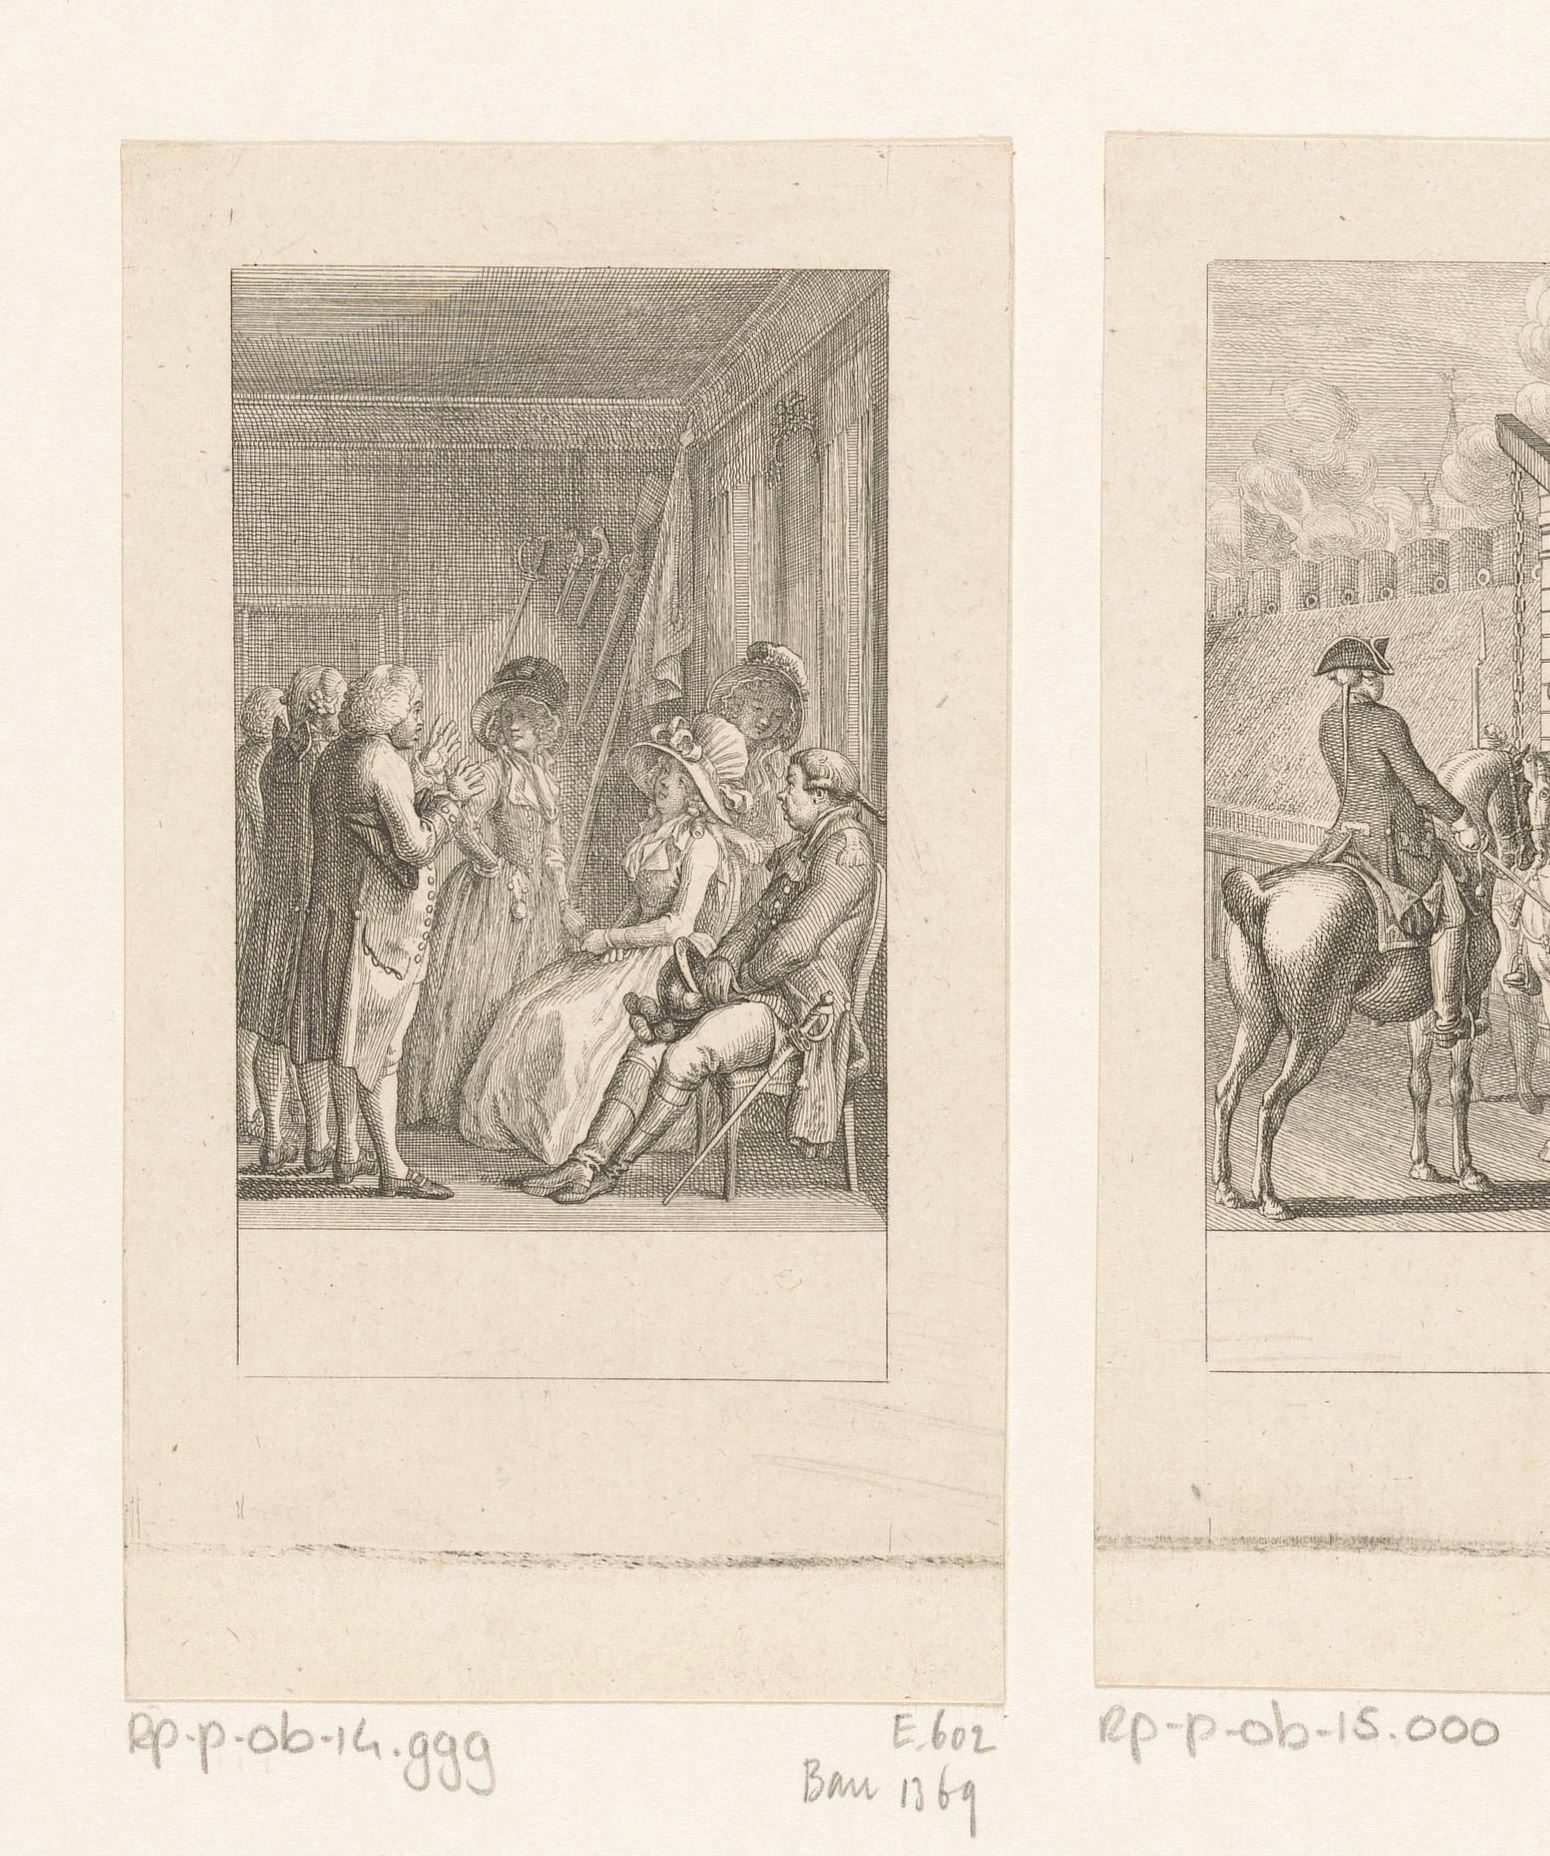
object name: print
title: De prinses in het slot bij Schoonhoven op 29 juni 1787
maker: daniel nikolaus chodowiecki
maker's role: draughtsman, print maker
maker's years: 1726-1801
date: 1788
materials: paper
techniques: etching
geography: berlin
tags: history, princess, conversation, dialogue; conversation piece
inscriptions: collector's mark: Lugt 2228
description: Latere staat gebruikt voor: Genealogischer-Militairischer Kalender auf das Jahr 1789. Berlijn: s.n., [1788].